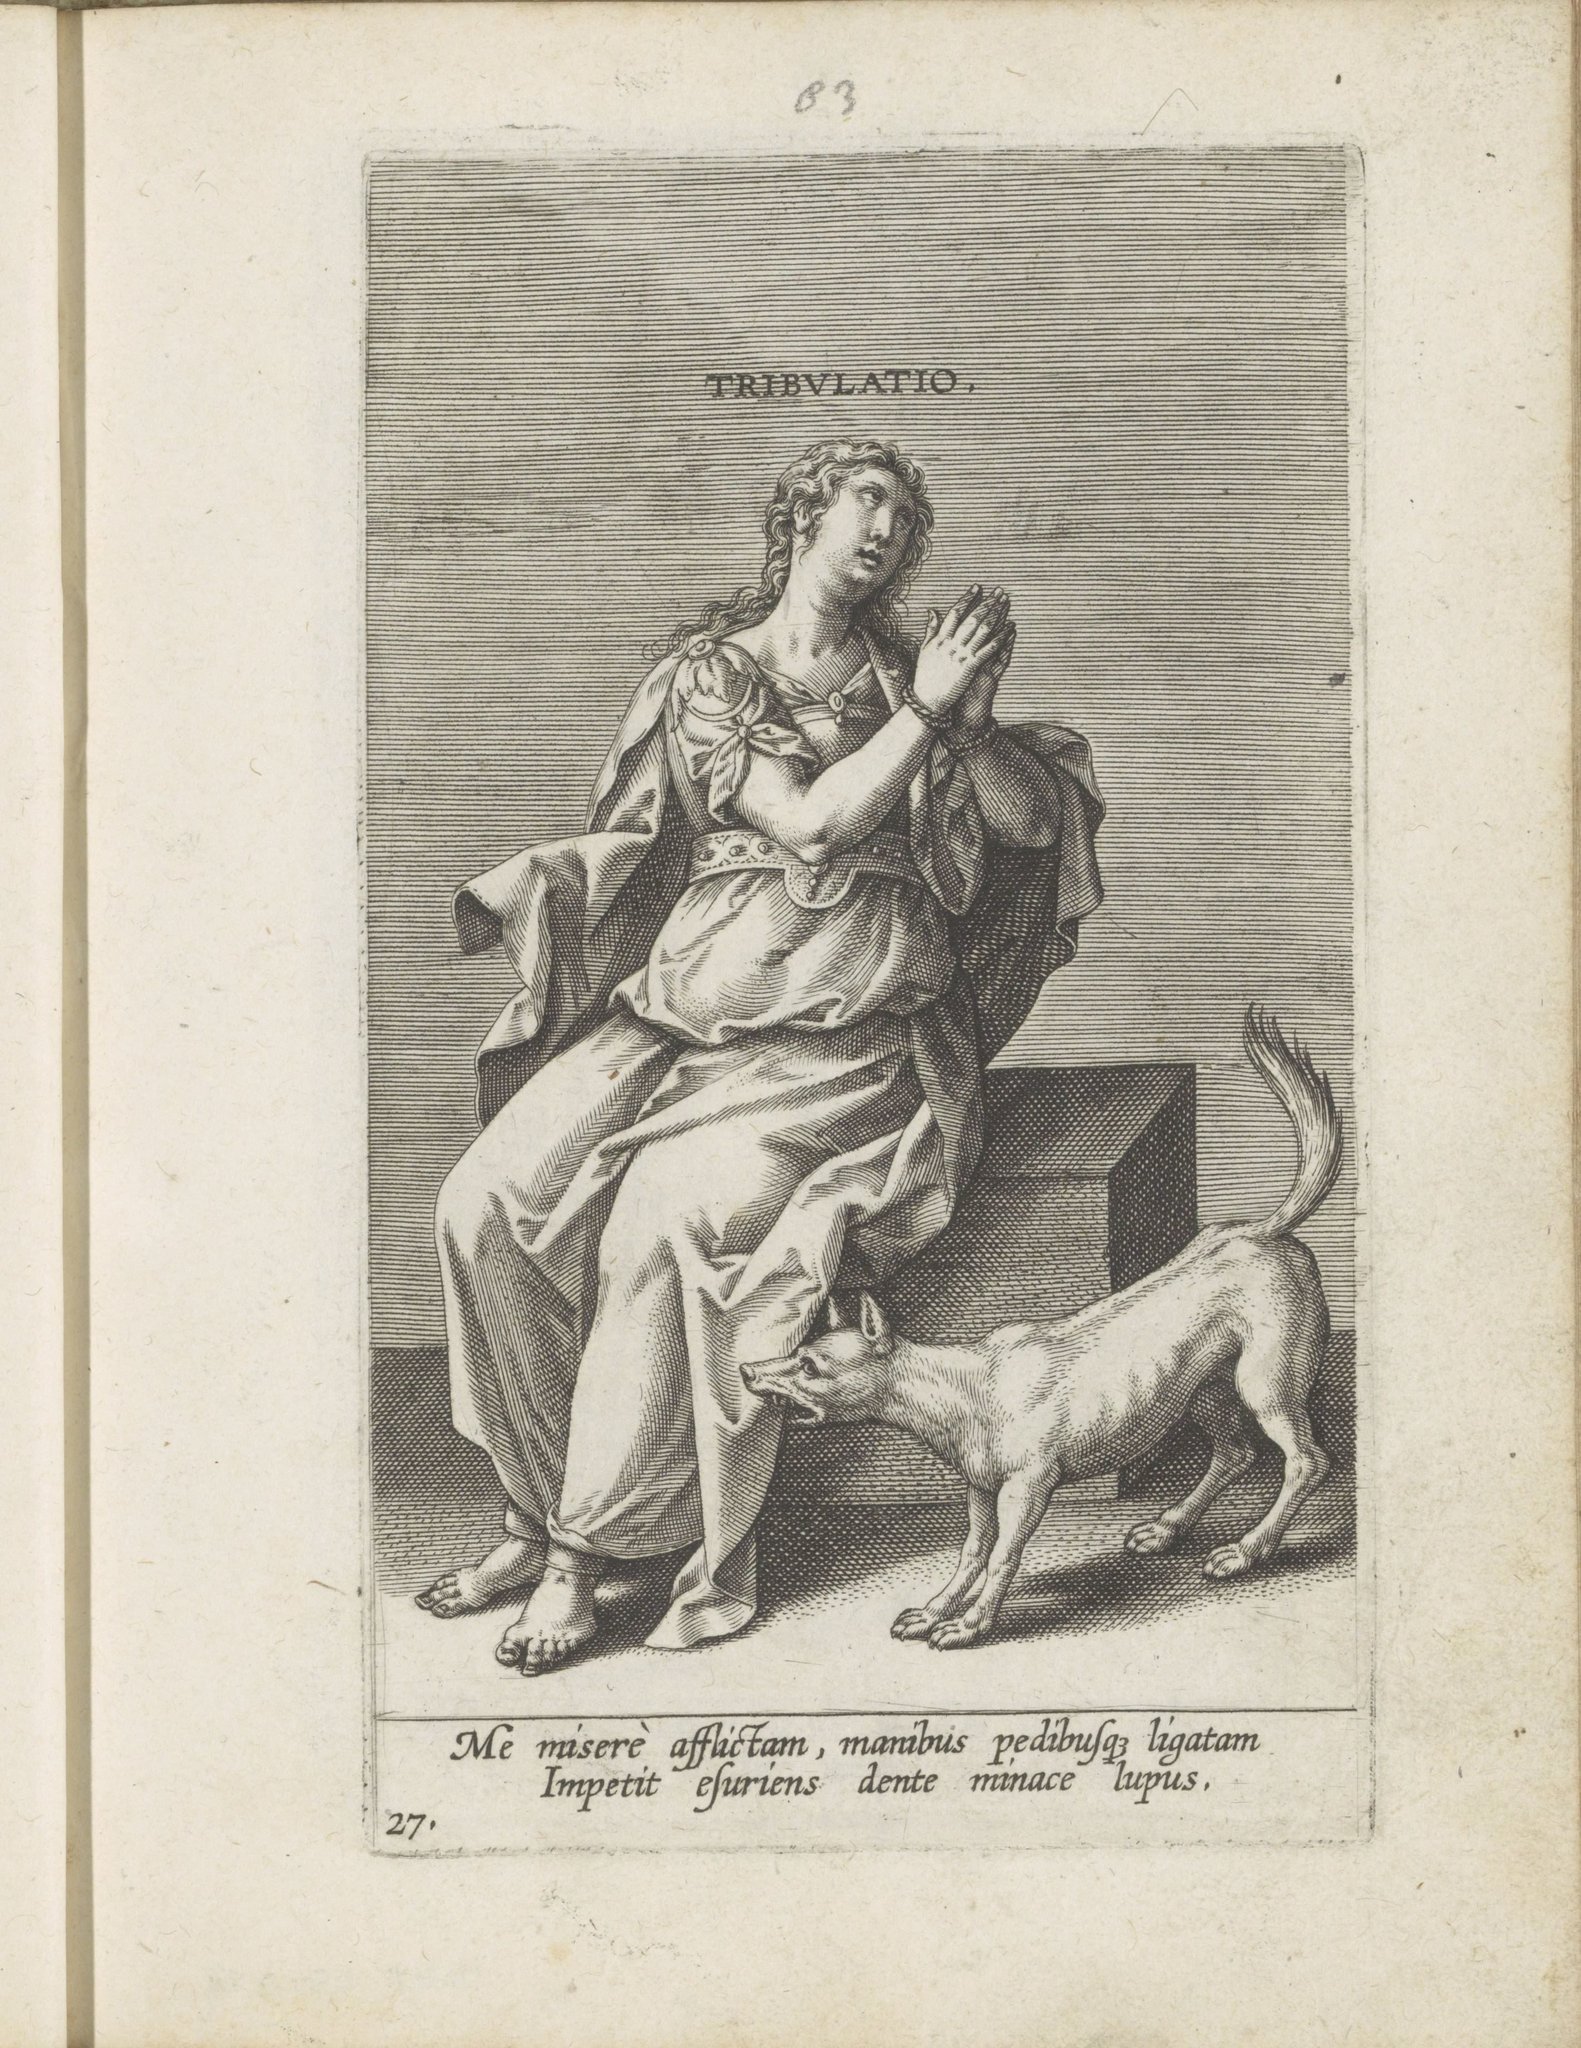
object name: print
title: Prosopographia, sive virtutum, animi, corporis, bonorum externorum, vitiorum, et affectuum variorum delineatio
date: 1585-1590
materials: paper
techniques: engraving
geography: southern netherlands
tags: torment; 'tribulatione' (ripa), beasts of prey, predatory animals: wolf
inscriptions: collector's mark: Lugt 2760, collector's mark: Lugt 2228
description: Een zittende vrouw met de voeten en handen gebonden. Met gevouwen handen kijkt ze smekend omhoog. Een wolf bijt in haar kleren. Onder de voorstelling twee regels tekst in het Latijn. De prent maakt deel uit van een album.